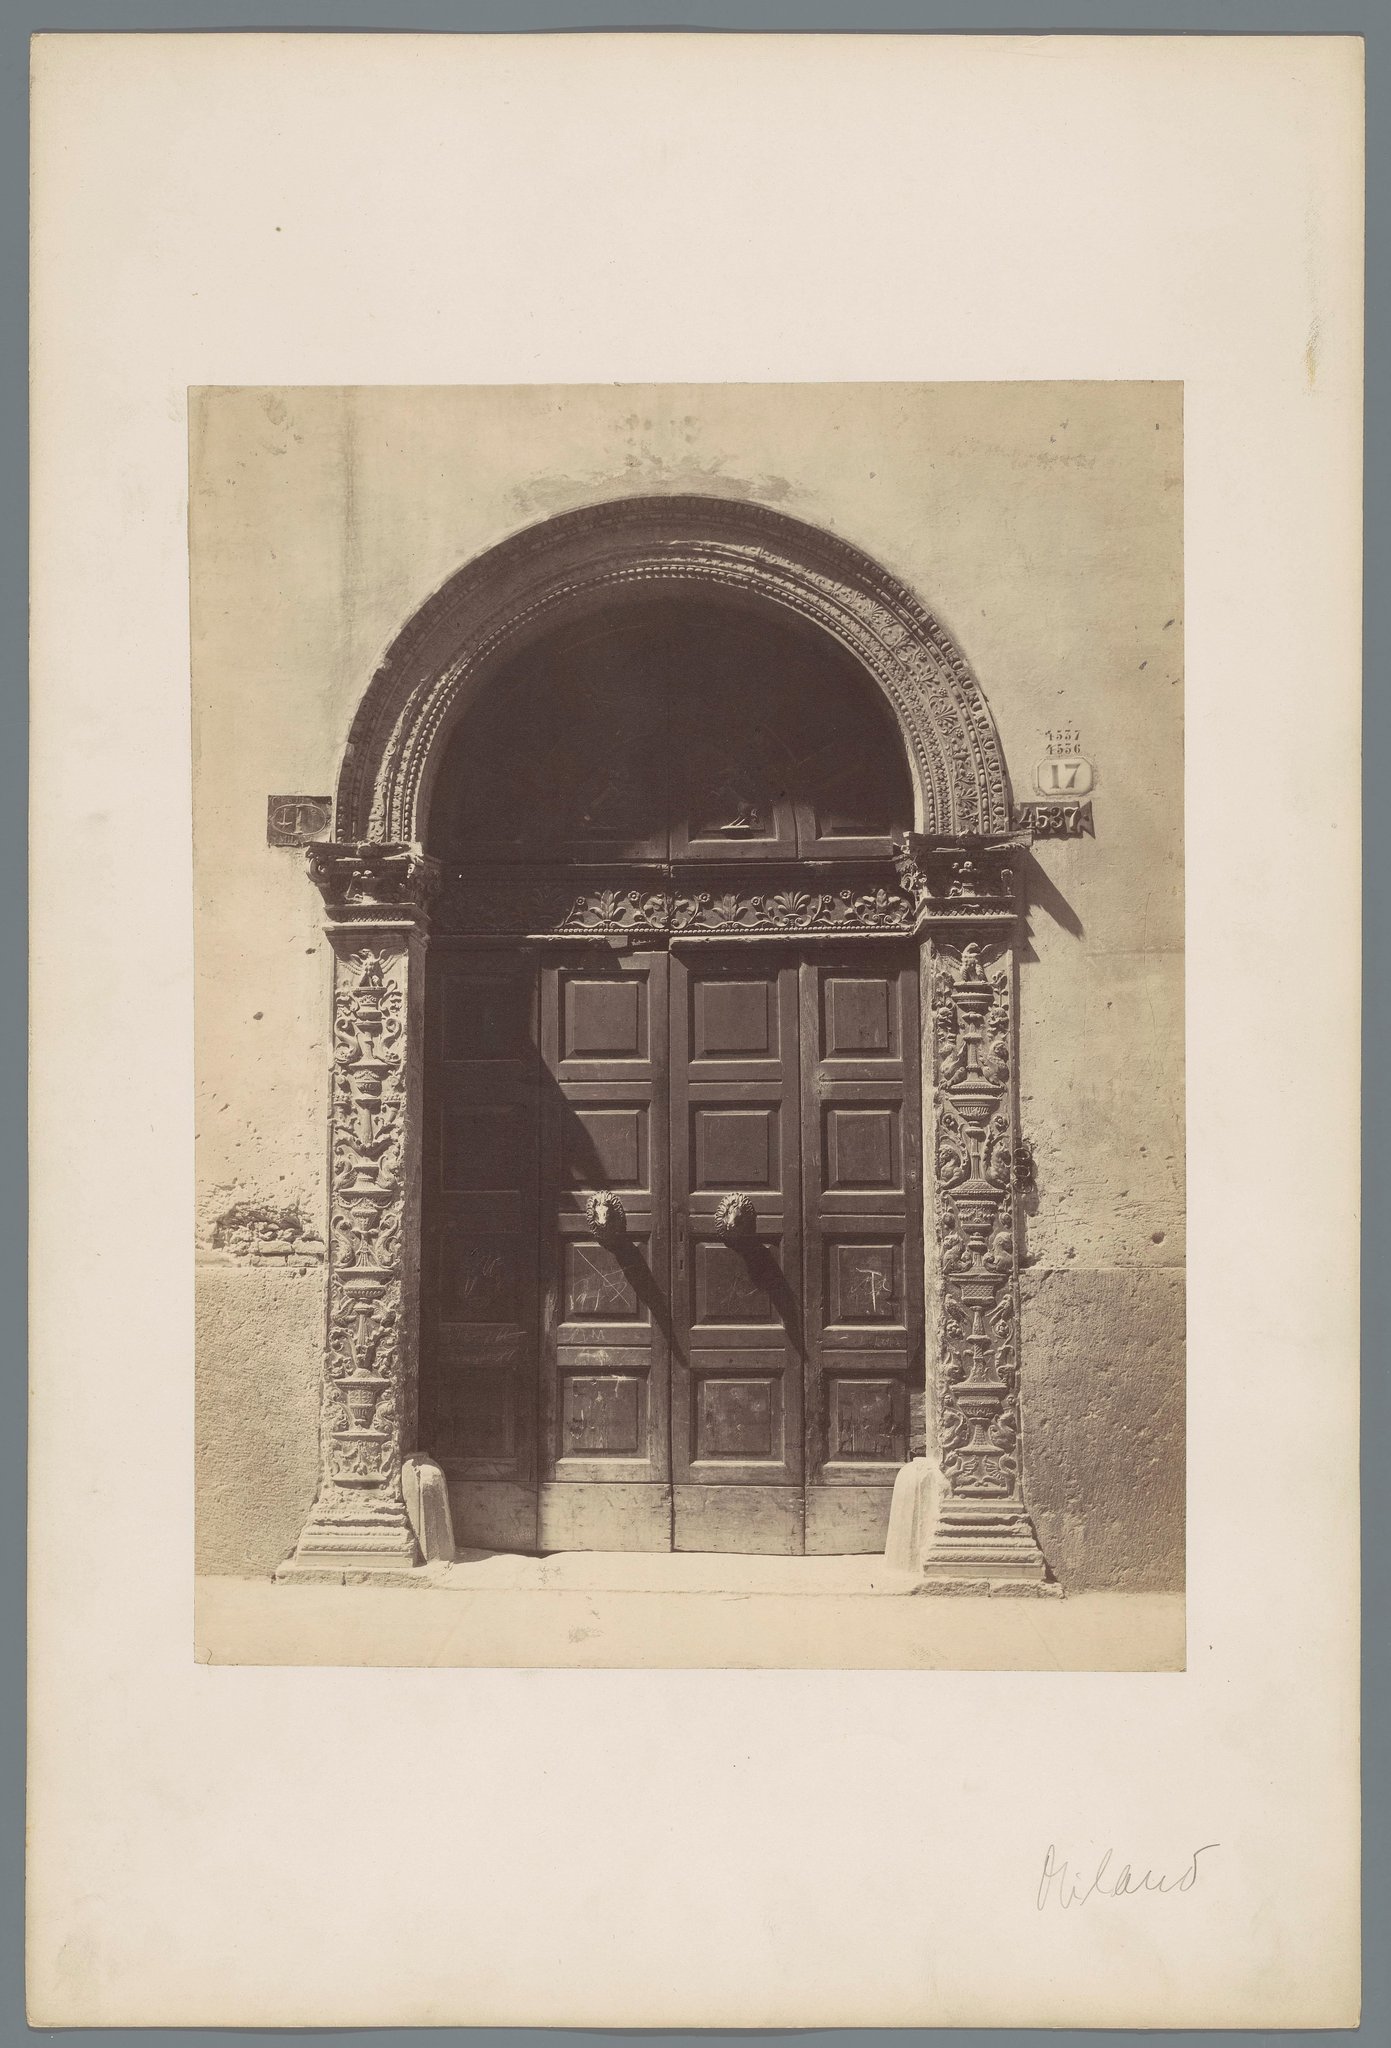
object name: photograph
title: Gedecoreerde deur van een gebouw in Milaan, Italië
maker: Anonymous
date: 1851-1900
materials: cardboard, paper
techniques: albumen print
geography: milan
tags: door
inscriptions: inscription: ‘RSKN 1’, collector's mark: ‘RIJKS SCHOOL VOOR KUNSTNIJVERHEID/ GROEP’